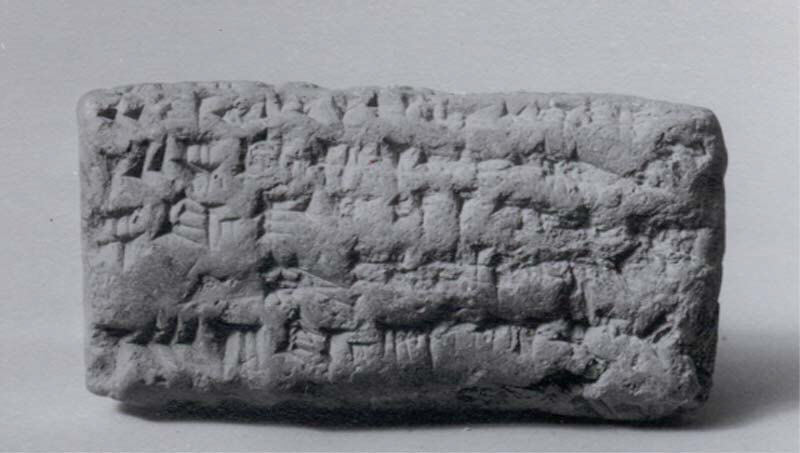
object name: cuneiform tablet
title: Cuneiform tablet: account of dates for imittu-rent, Ebabbar archive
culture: babylonian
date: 616 BCE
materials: clay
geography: mesopotamia